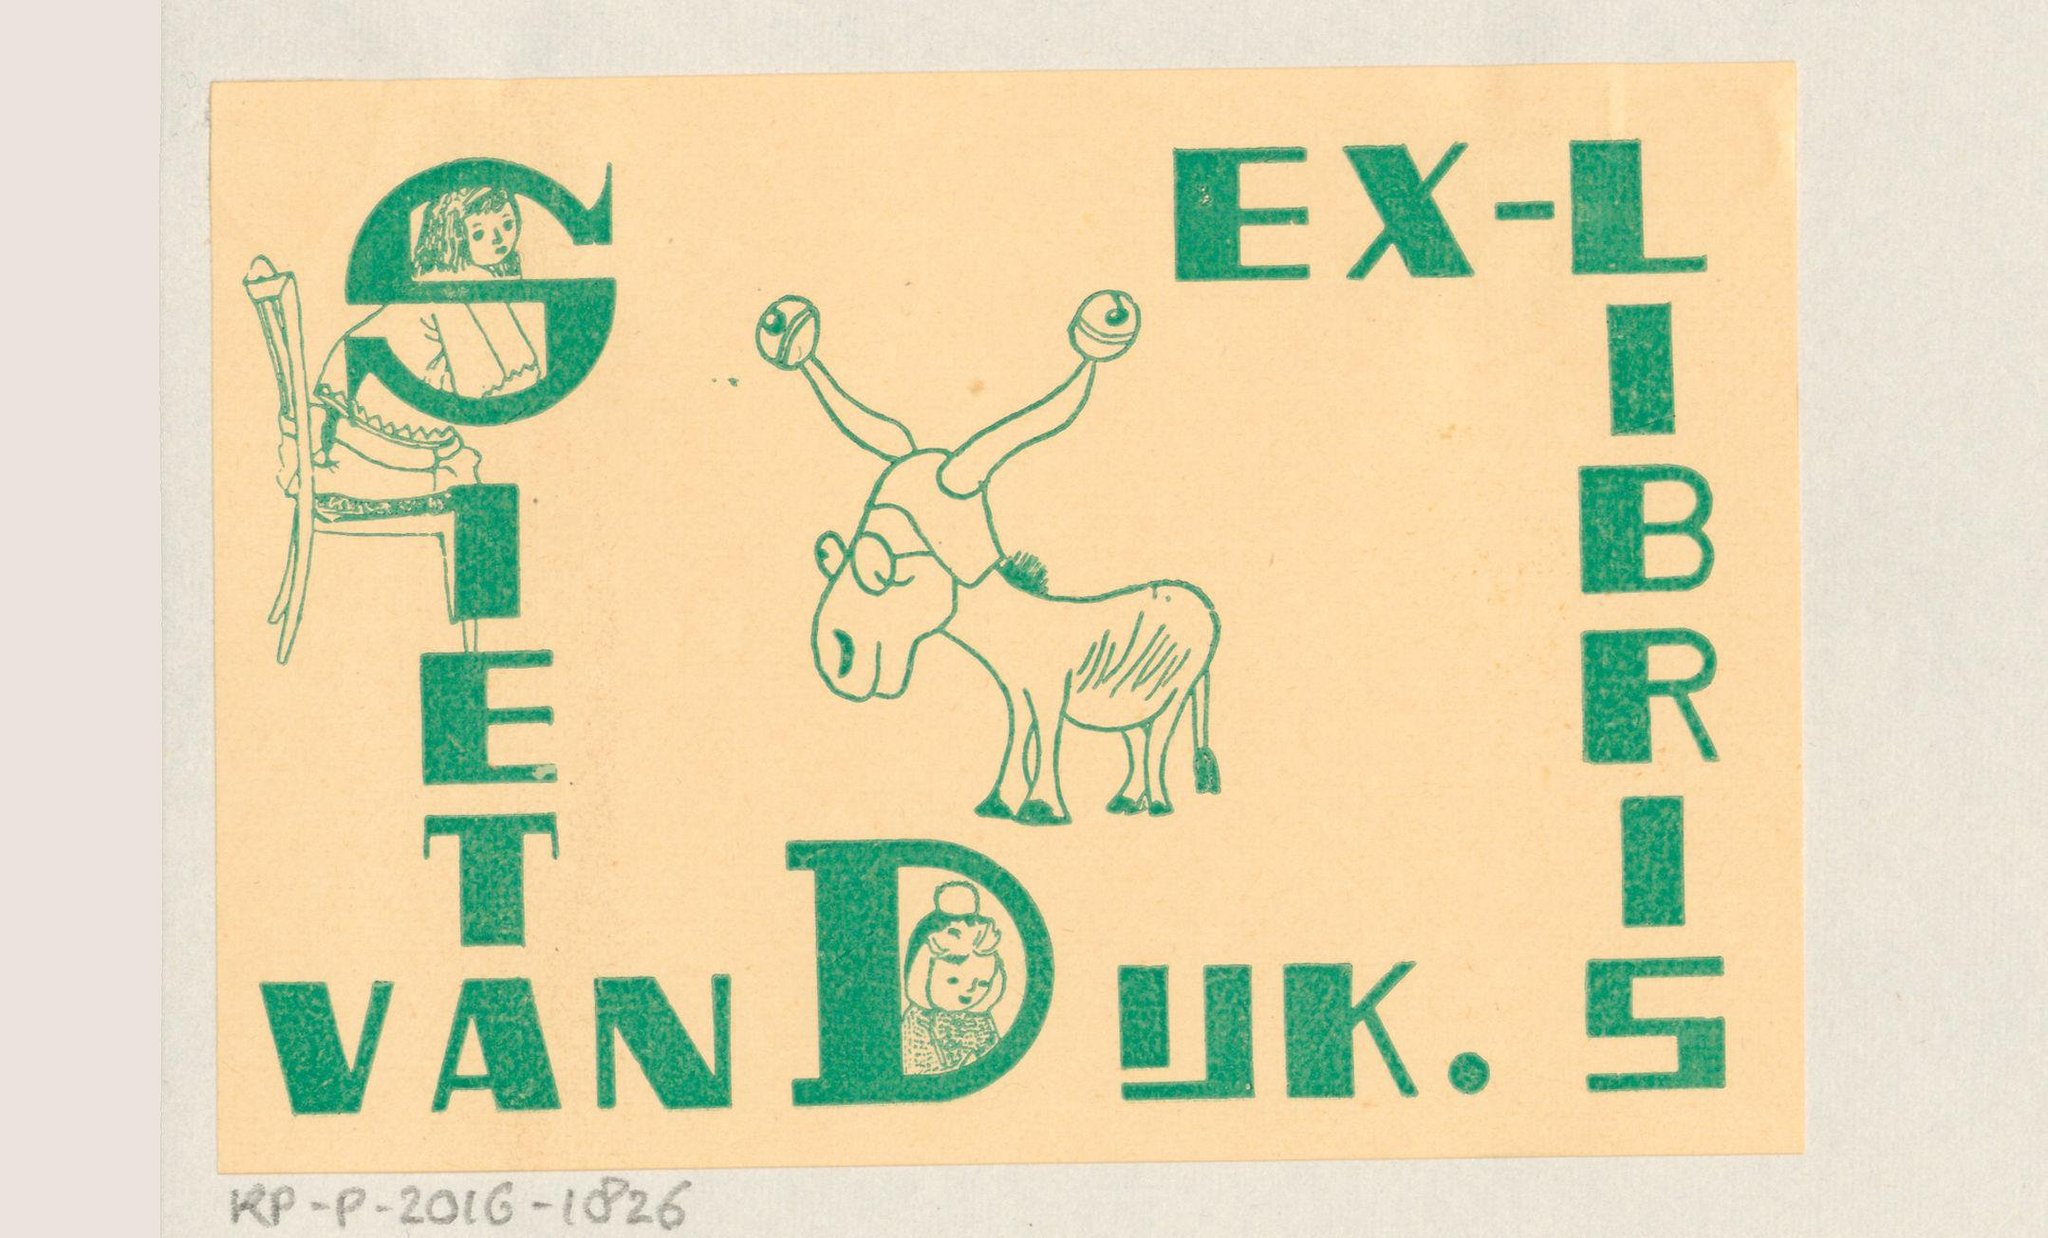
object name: bookplate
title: Ex libris van Siet van Dijk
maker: constant van dijk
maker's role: print maker, printer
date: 1946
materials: paper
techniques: printing block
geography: rotterdam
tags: children's art, tales and fairy tales